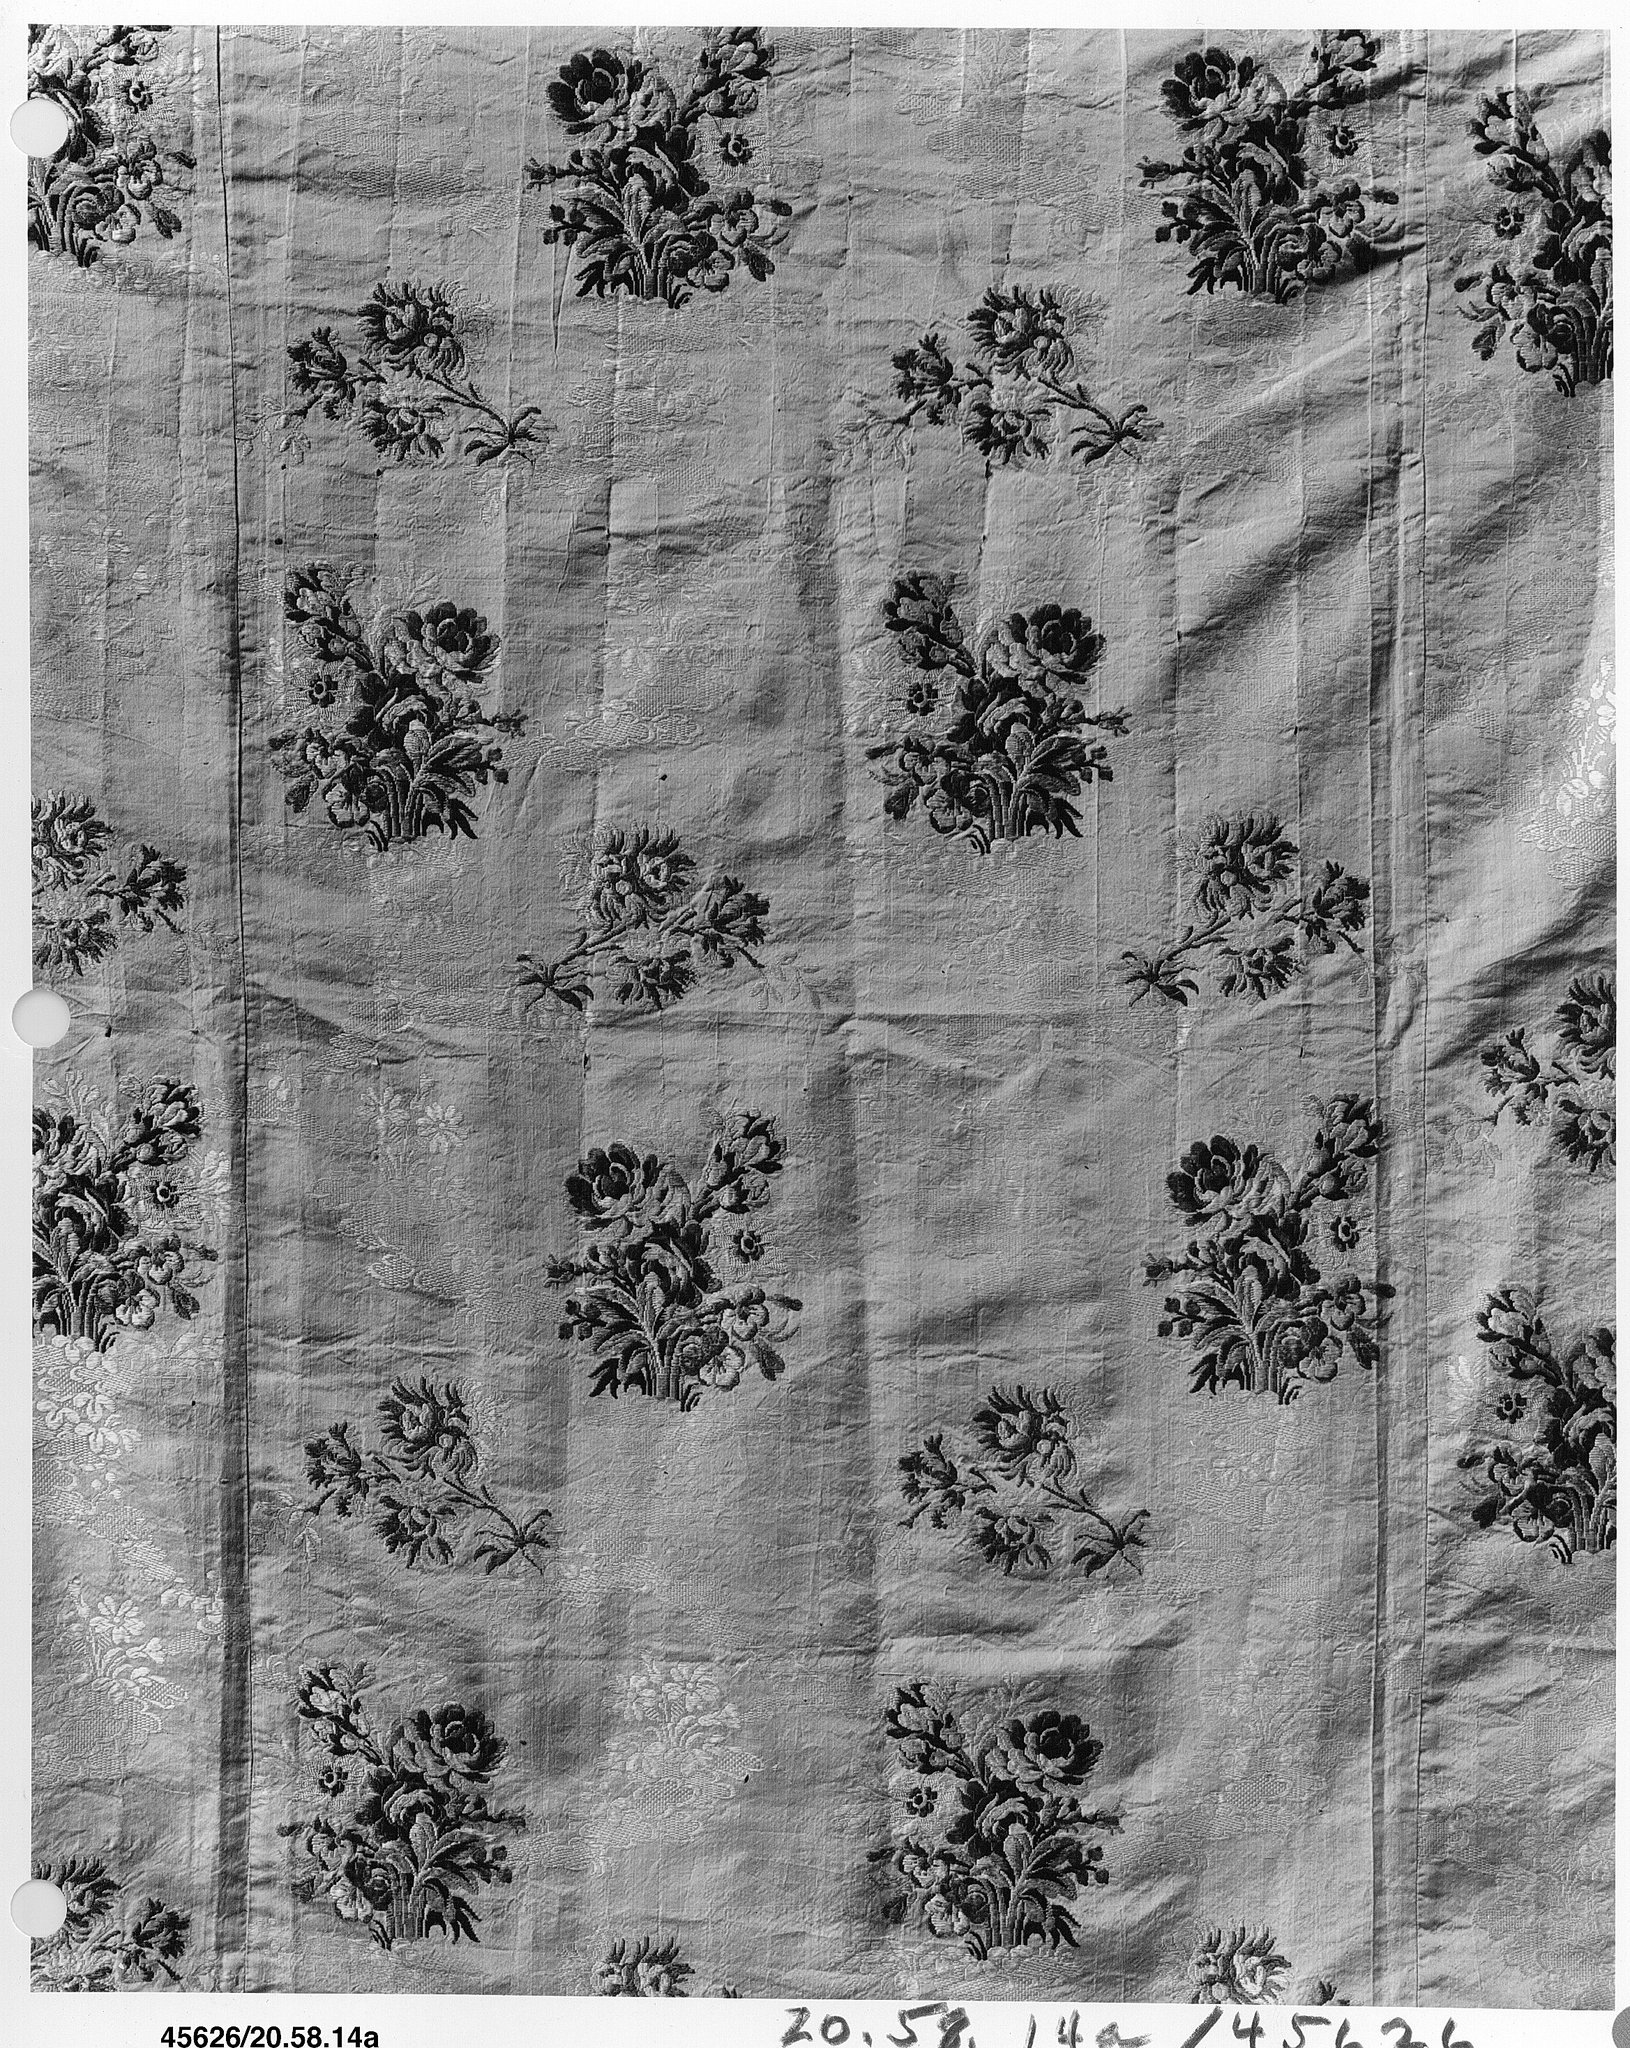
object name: piece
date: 1750-1760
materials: silk